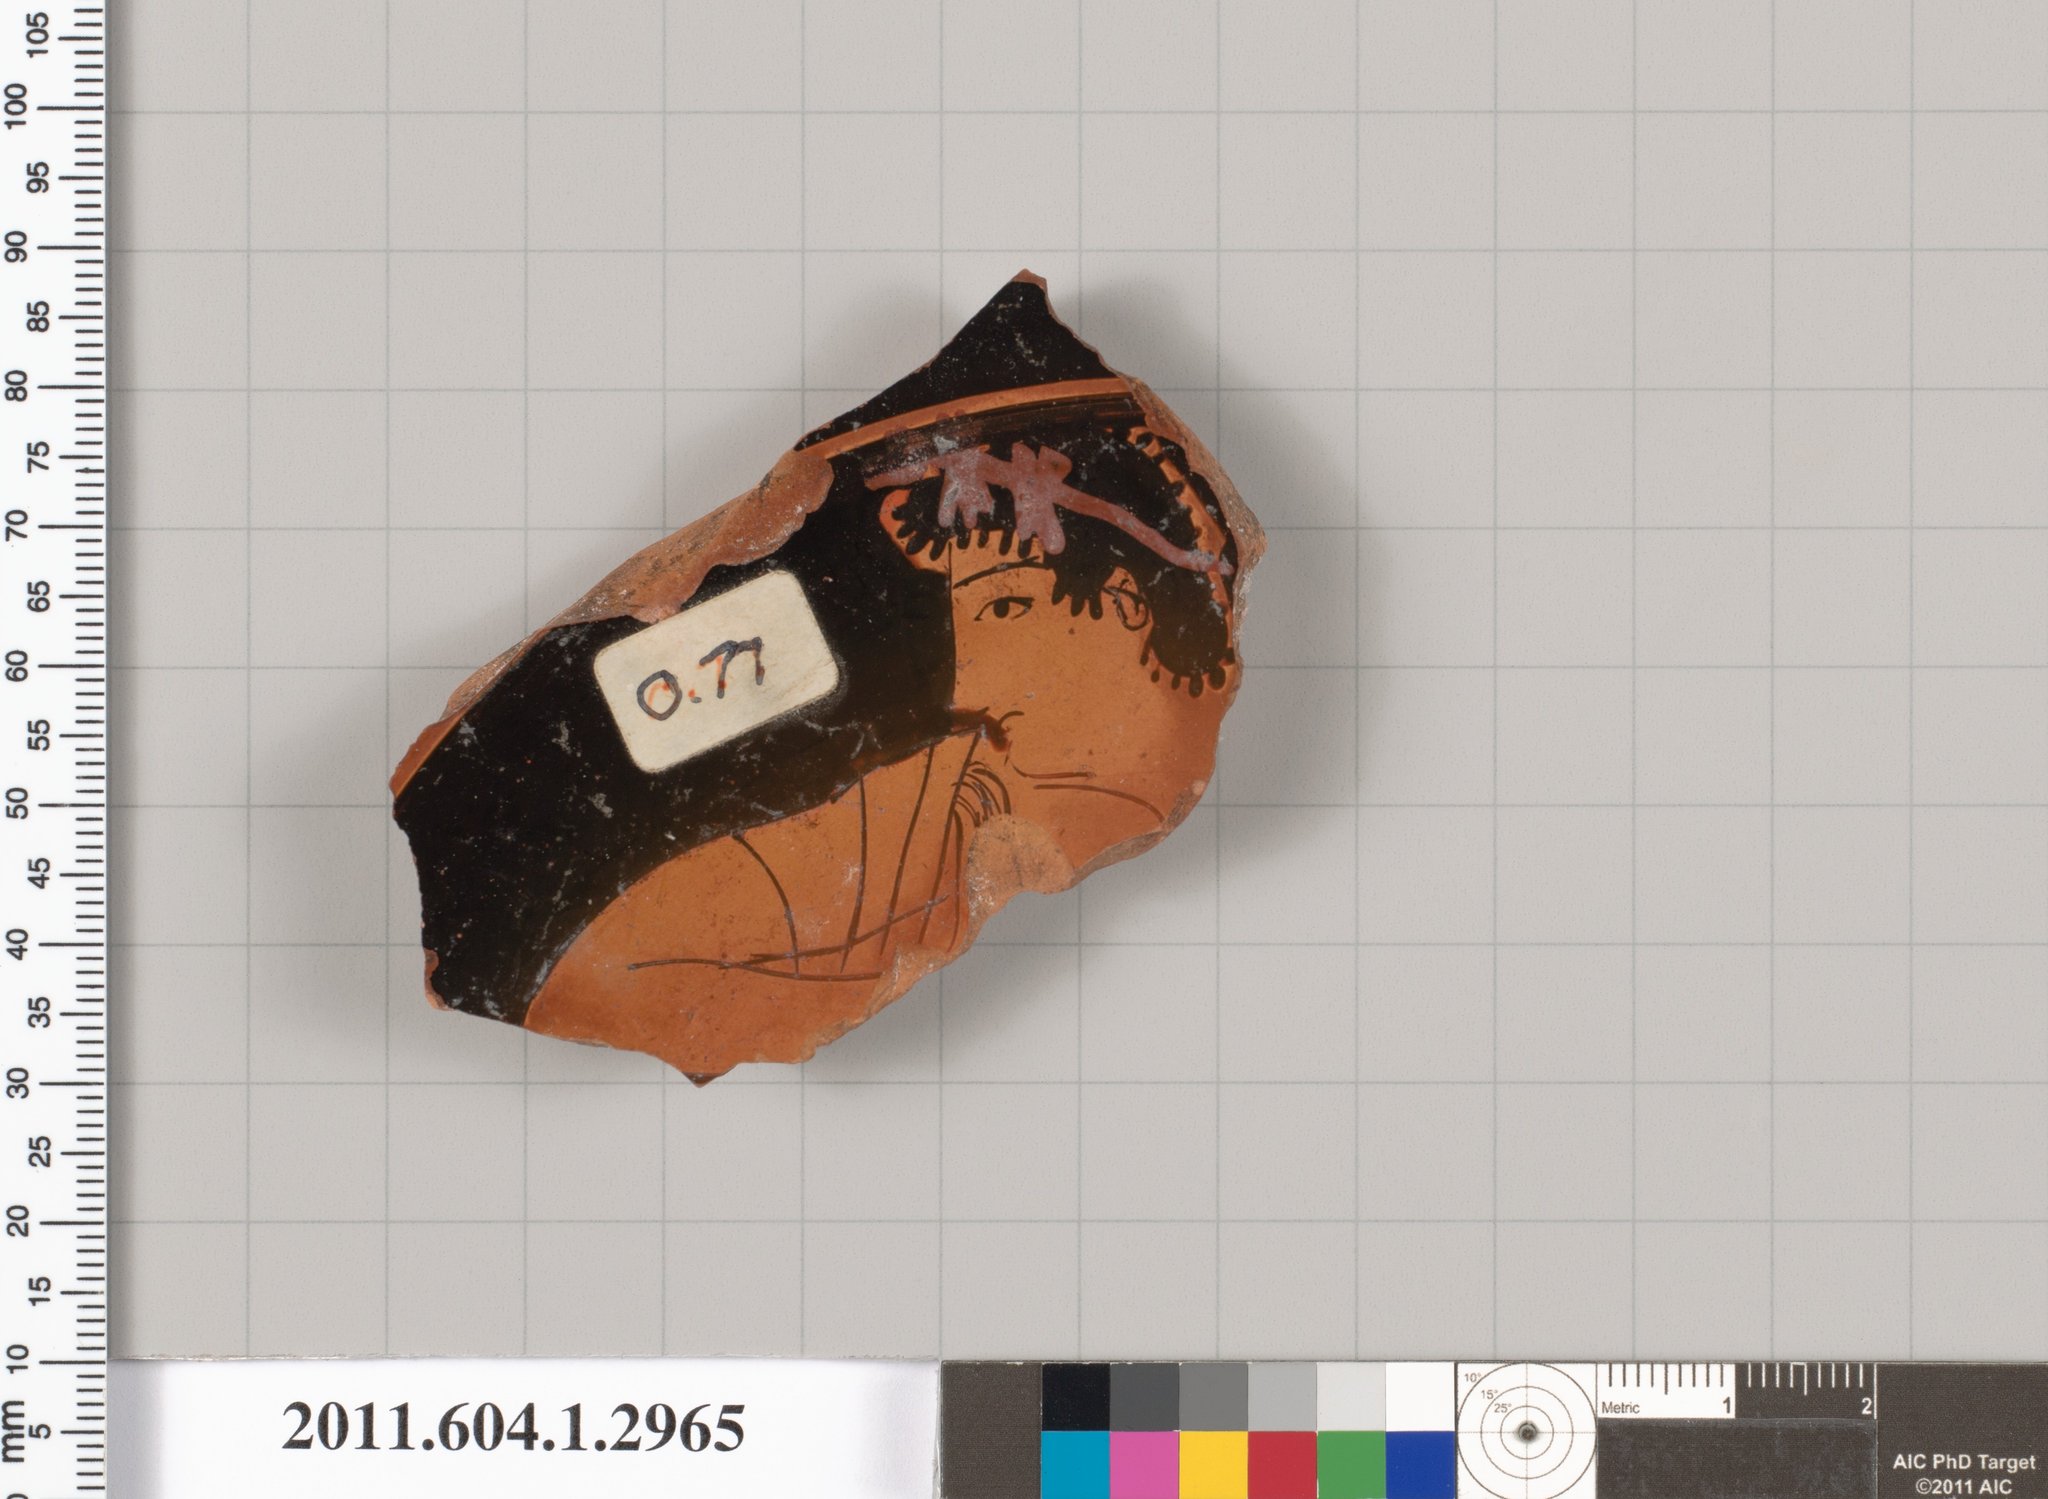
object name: kylix fragment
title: Terracotta fragment of a kylix (drinking cup)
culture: greek, attic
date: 520-500 BCE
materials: terracotta